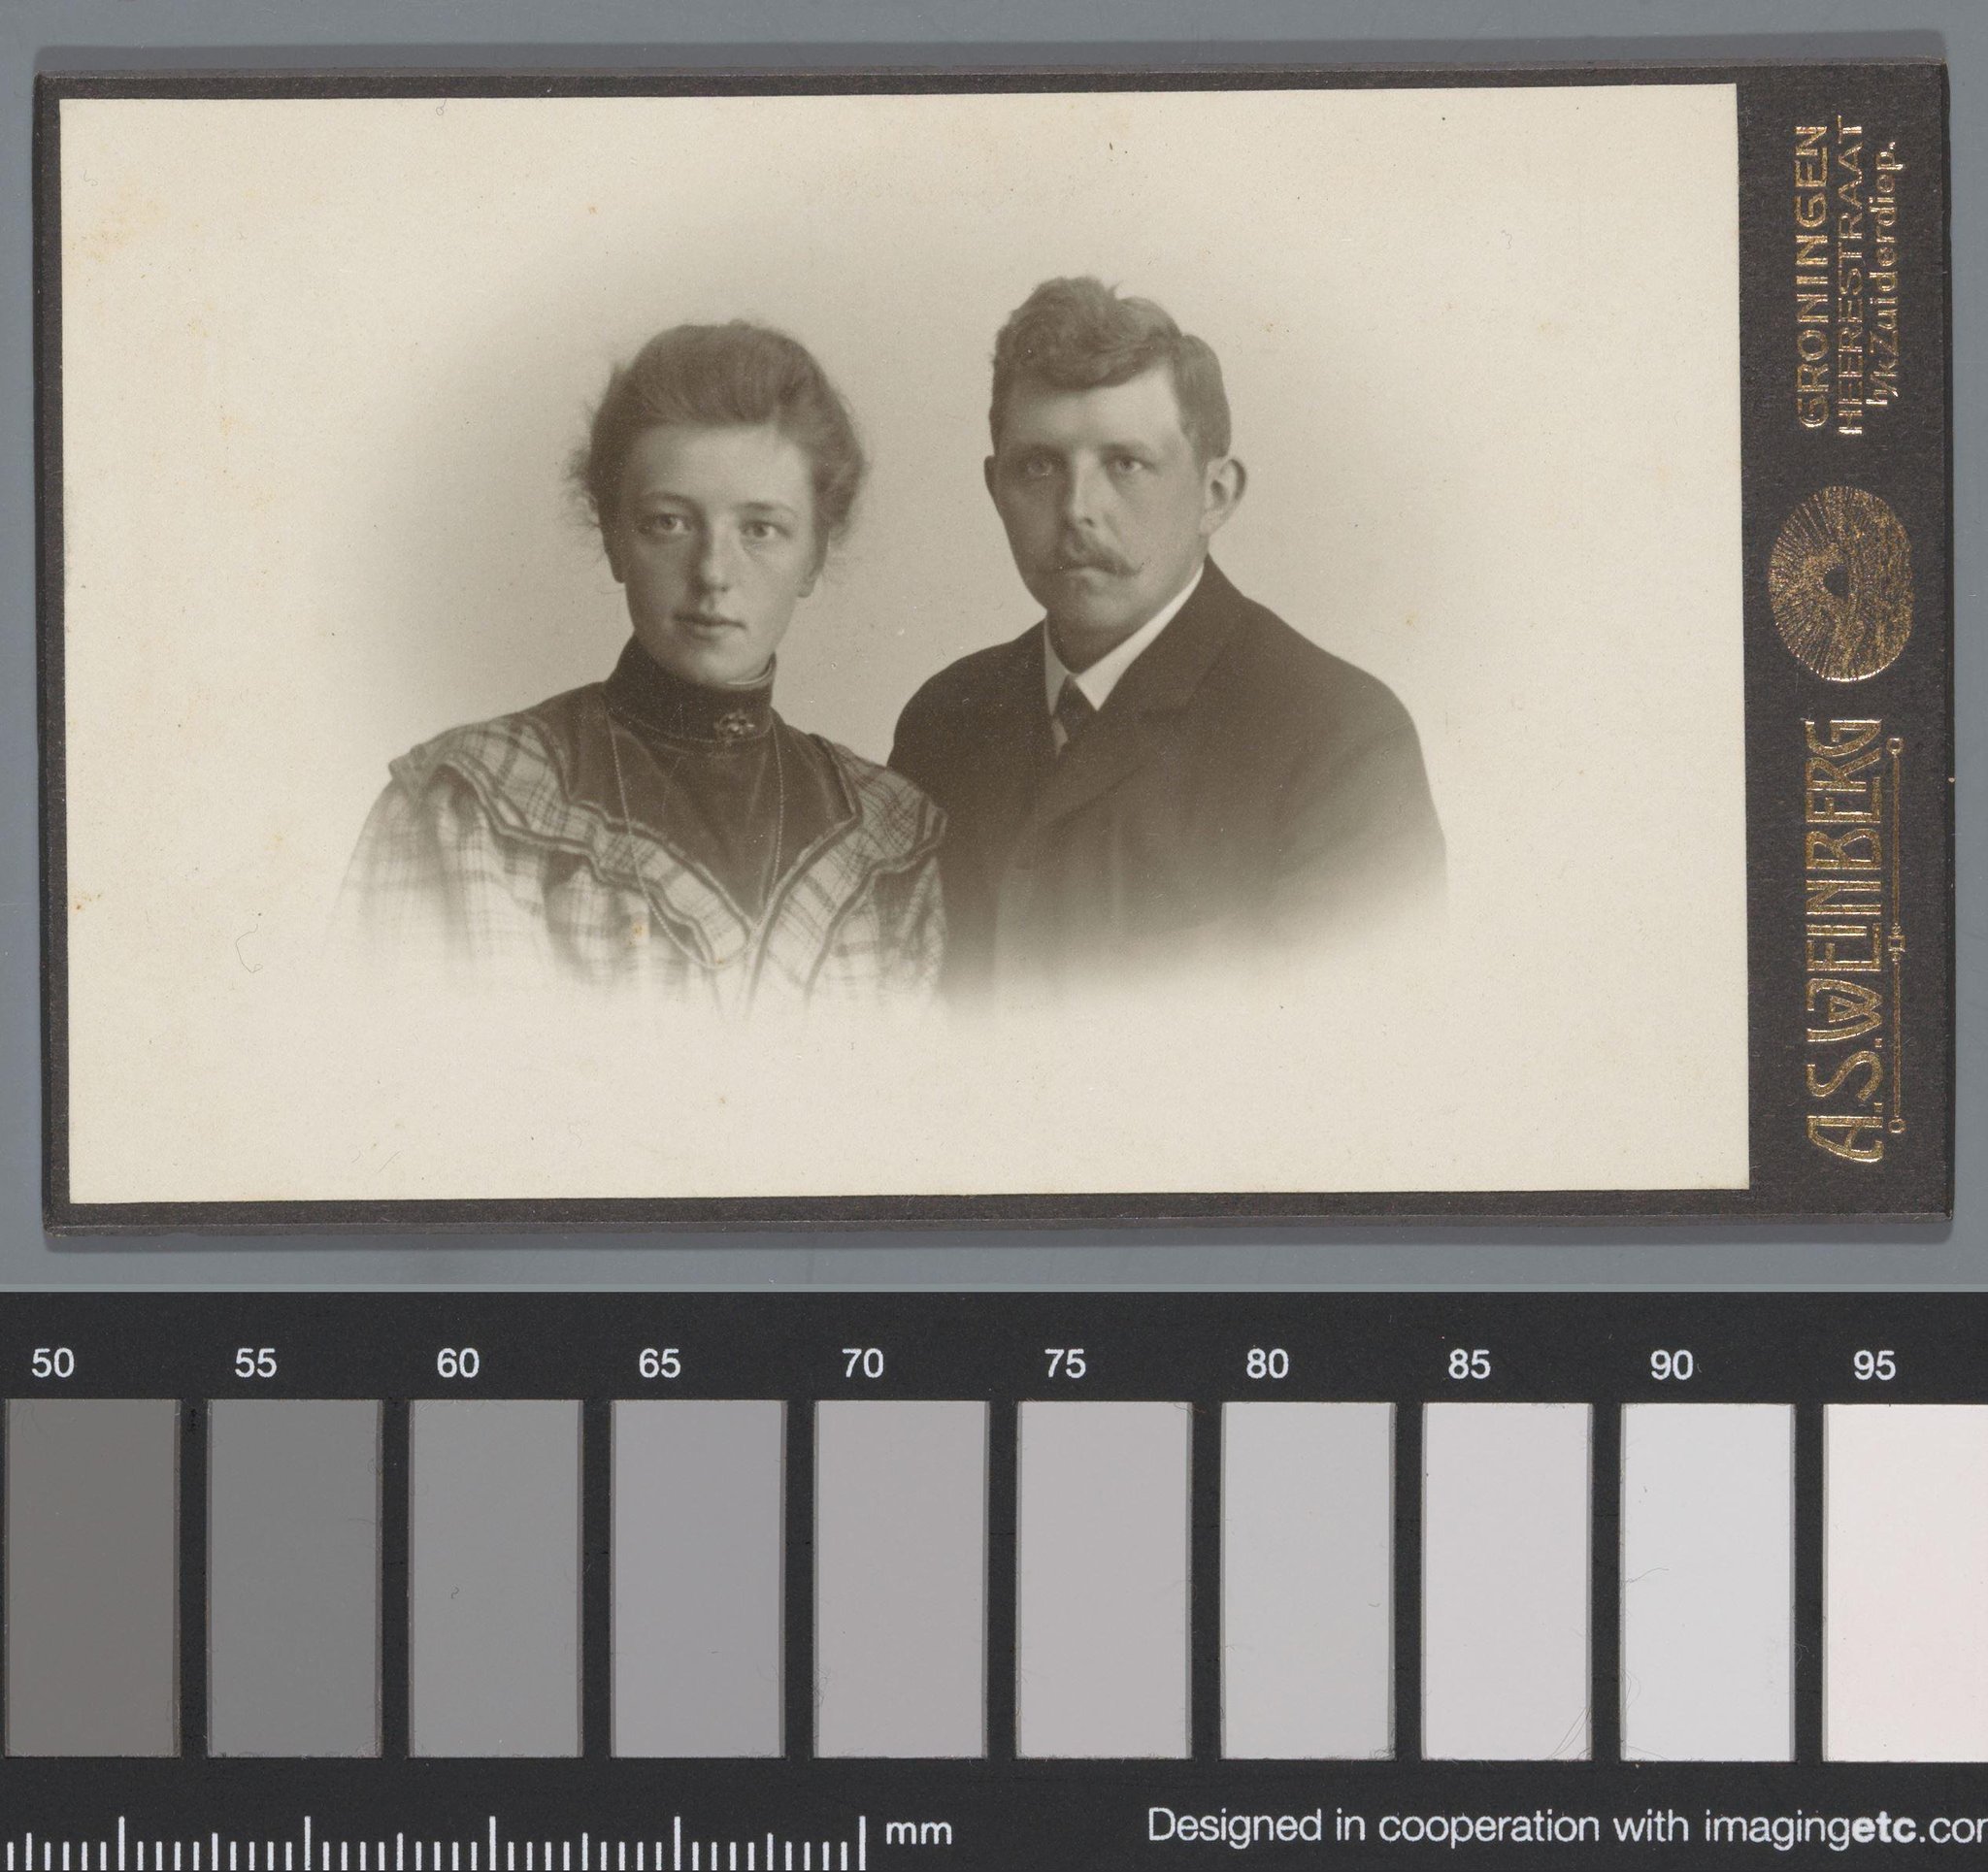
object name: photograph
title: Portret van een onbekende man en vrouw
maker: abraham salomon weinberg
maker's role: fotograaf, hofleverancier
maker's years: 1869-1932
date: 1896-1904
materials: paper, cardboard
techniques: gelatin silver print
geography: groningen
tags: adult woman, adult man, anonymous historical person portrayed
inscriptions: address: ‘GRONINGEN/ HEERESTRAAT/ h/k Zuiderdiep.’